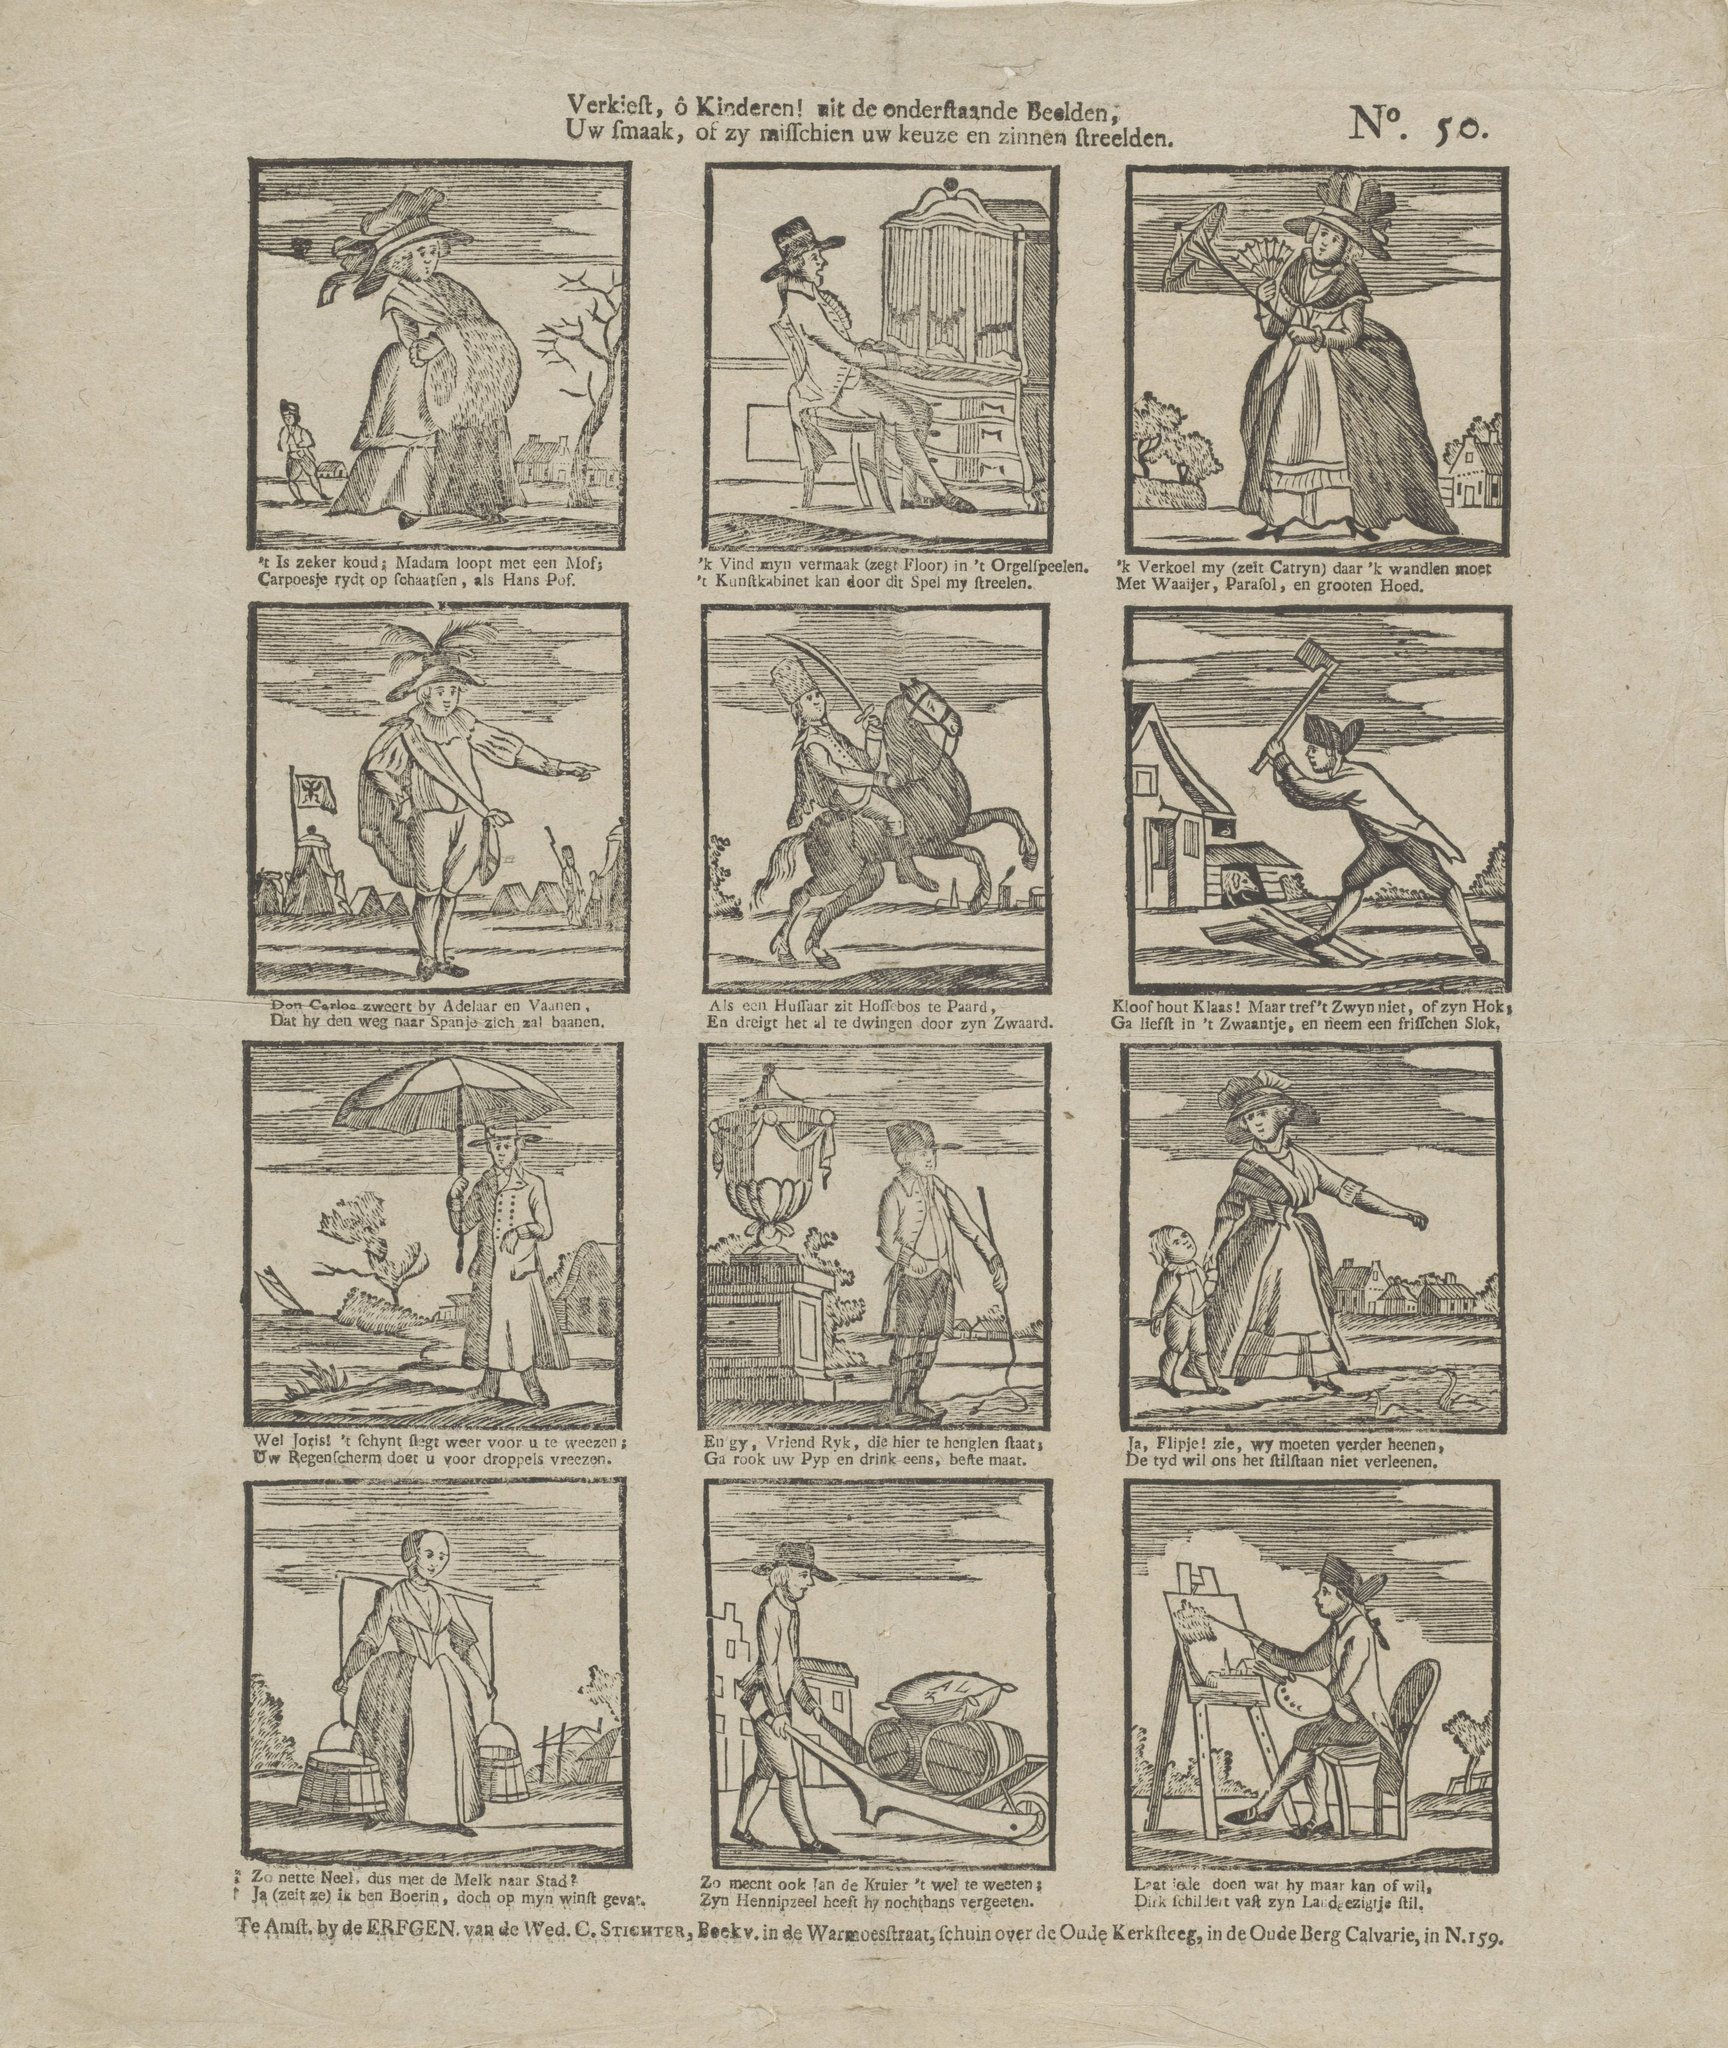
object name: print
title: Verkiest, ô kinderen! uit de onderstaande beelden, / Uw smaak, of zy misschien uw keuze en zinnen streelden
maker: Anonymous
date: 1715-1813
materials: paper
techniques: letterpress printing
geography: amsterdam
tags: musician at work, craft-production, skilled handiwork, human types, milkmaid, crafts and industries, working situations ~ painter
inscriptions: collector's mark: Lugt 2760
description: Blad met 12 voorstellingen van verschillende figuren, ambachtslieden en beroepen. Onder elke afbeelding een tweeregelig vers. Genummerd rechtsboven: No. 50.